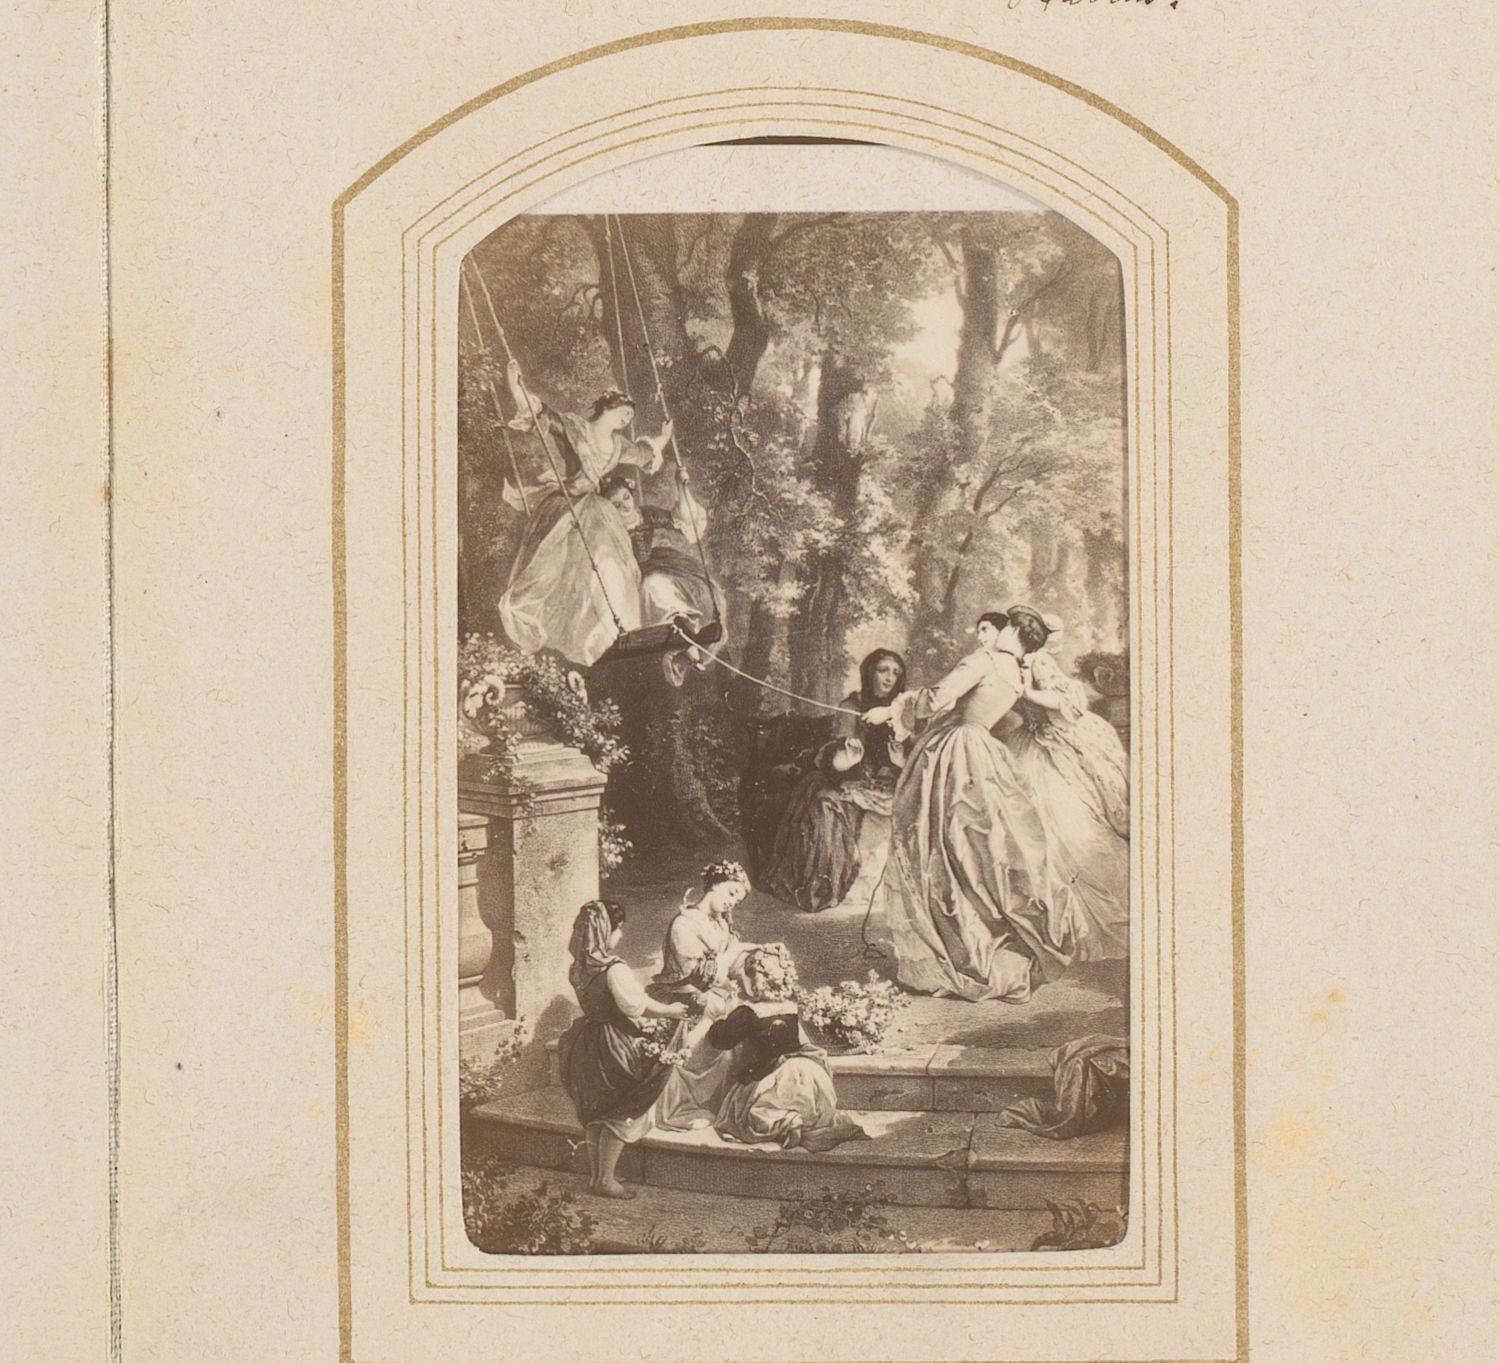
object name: reproduction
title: Fotoreproductie van Le Printemps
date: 1870-1890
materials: cardboard, photographic support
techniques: albumen print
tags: adolescent, young woman, maiden, child, public gardens, park, painting, drawing and the graphic arts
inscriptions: annotation: ‘[...]’, inscription: ‘Jourdan,/ 48. Le Printemps.’